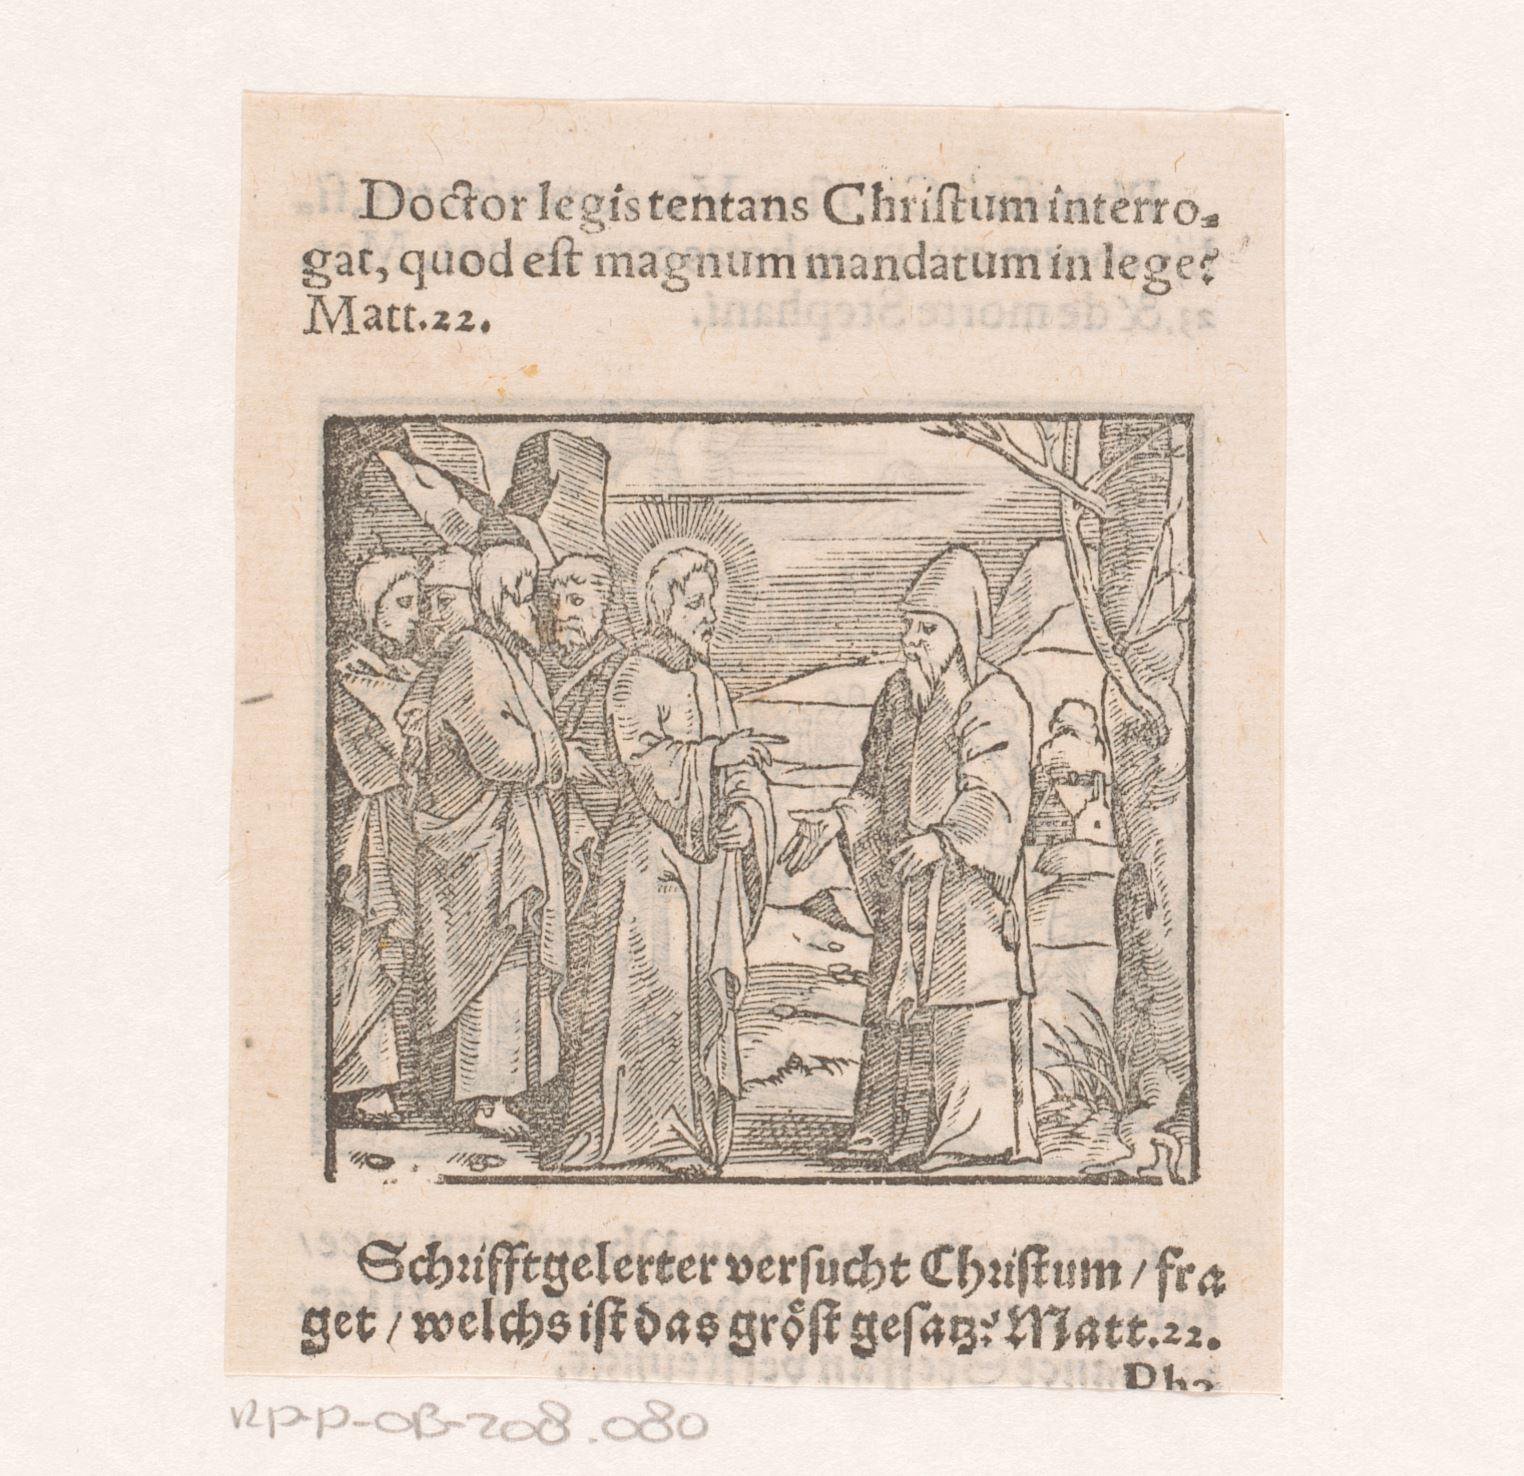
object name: print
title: Christus in gesprek met een Farizeeër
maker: Anonymous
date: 1600-1699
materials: paper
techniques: letterpress printing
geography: netherlands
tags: pharisees and sadducees opposing christ